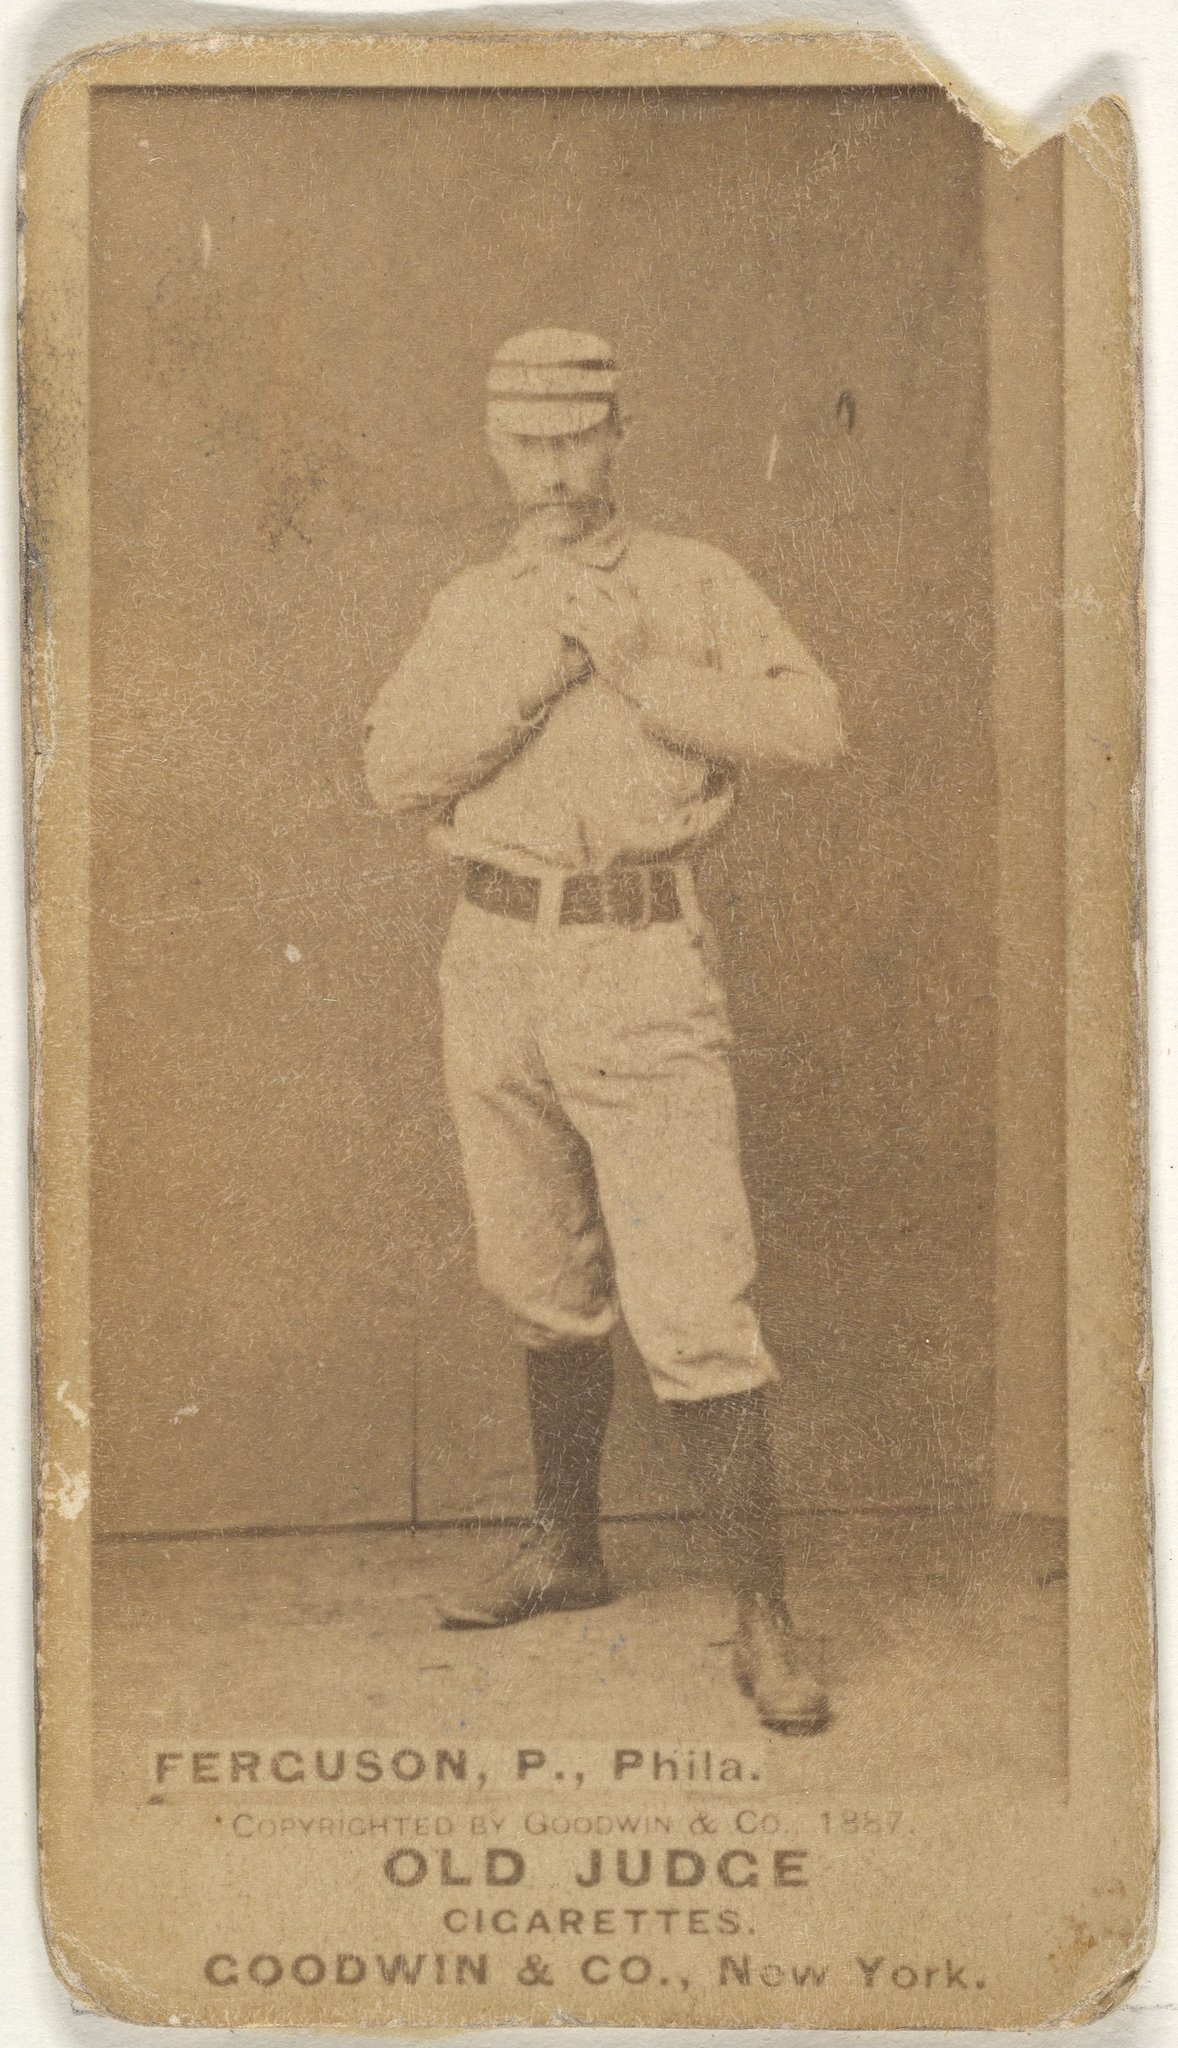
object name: baseball card, photograph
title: Charles J. "Charlie" Ferguson, Pitcher, Philadelphia, from the Old Judge series (N172) for Old Judge Cigarettes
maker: goodwin & company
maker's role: publisher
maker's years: 1850-1950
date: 1887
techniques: albumen silver print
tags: men,portraits,baseball,athletes